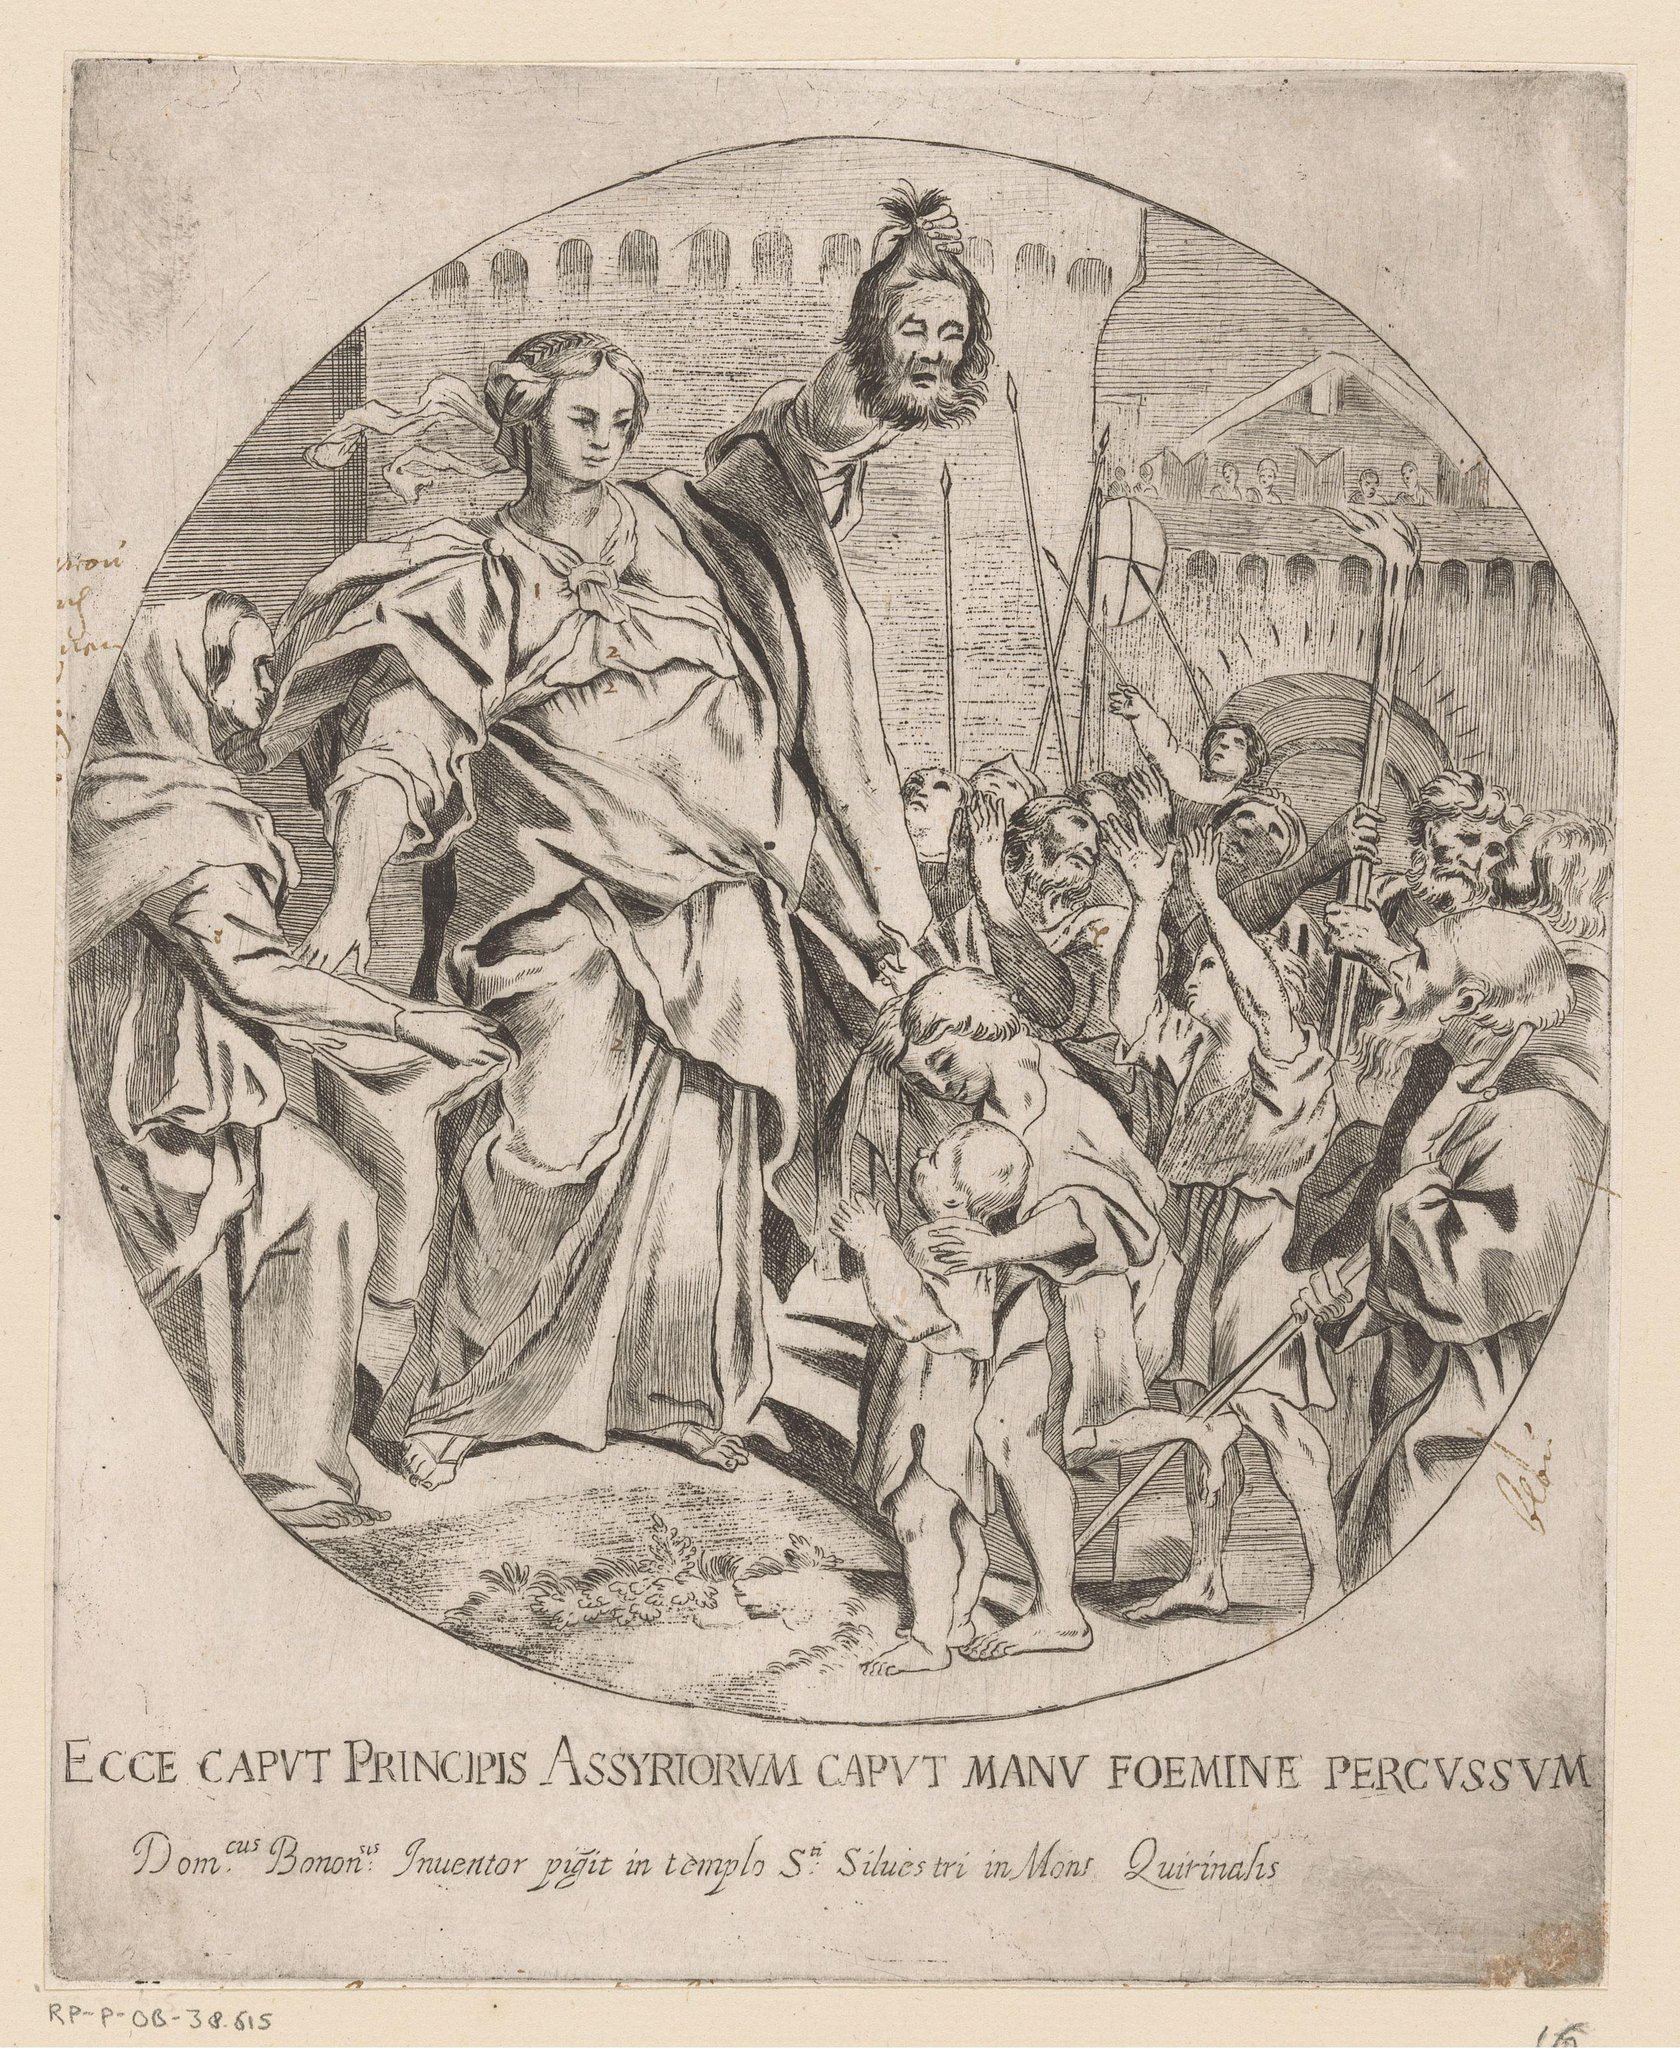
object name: print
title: Judit toont het hoofd van Holofernes aan het volk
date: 1591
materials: paper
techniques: etching, intaglio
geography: rome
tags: judith shows holofernes' head to the people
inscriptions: collector's mark: Lugt 240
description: Judit toont het hoofd van Holofernes aan het volk, naast haar staat haar dienstmaagd. Zij houdt de zak open waarin het hoofd opgeborgen was. Latijnse tekst in ondermarge.